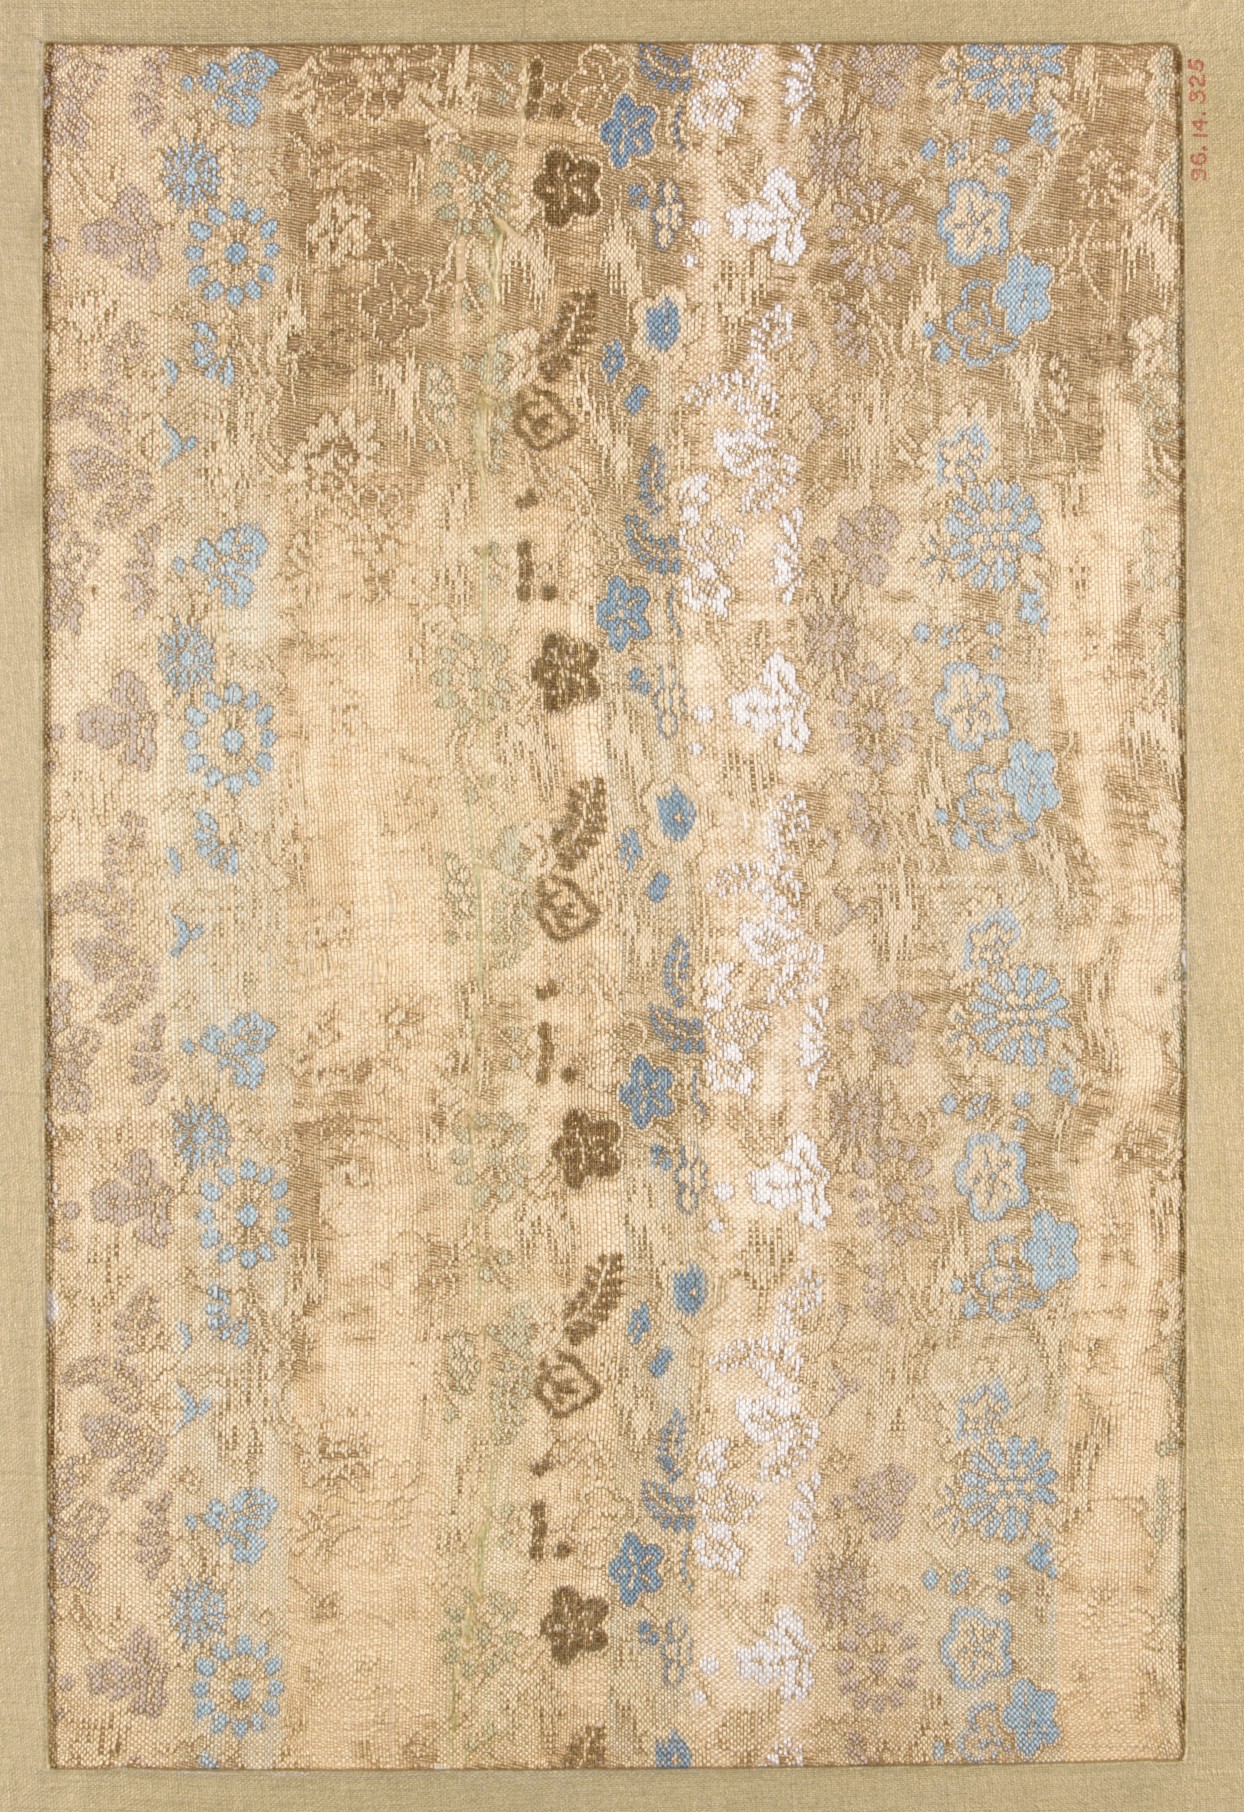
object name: piece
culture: japanese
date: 1701-1900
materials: silk